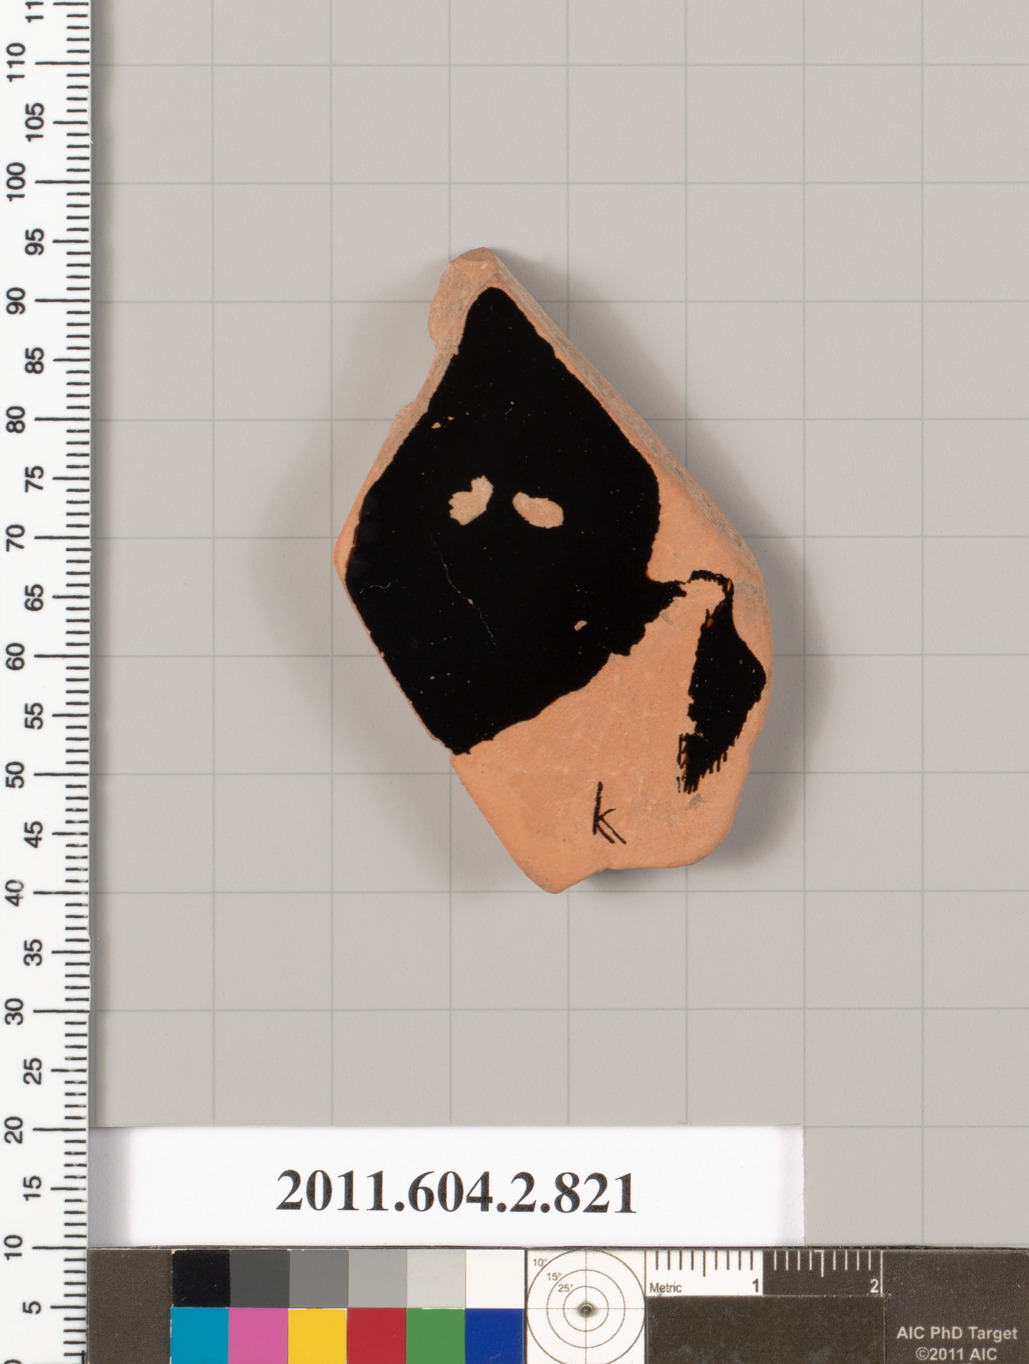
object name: bell krater fragment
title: Terracotta fragment of a bell-krater (bowl for mixing wine and water)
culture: greek, attic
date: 475-451 BCE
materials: terracotta